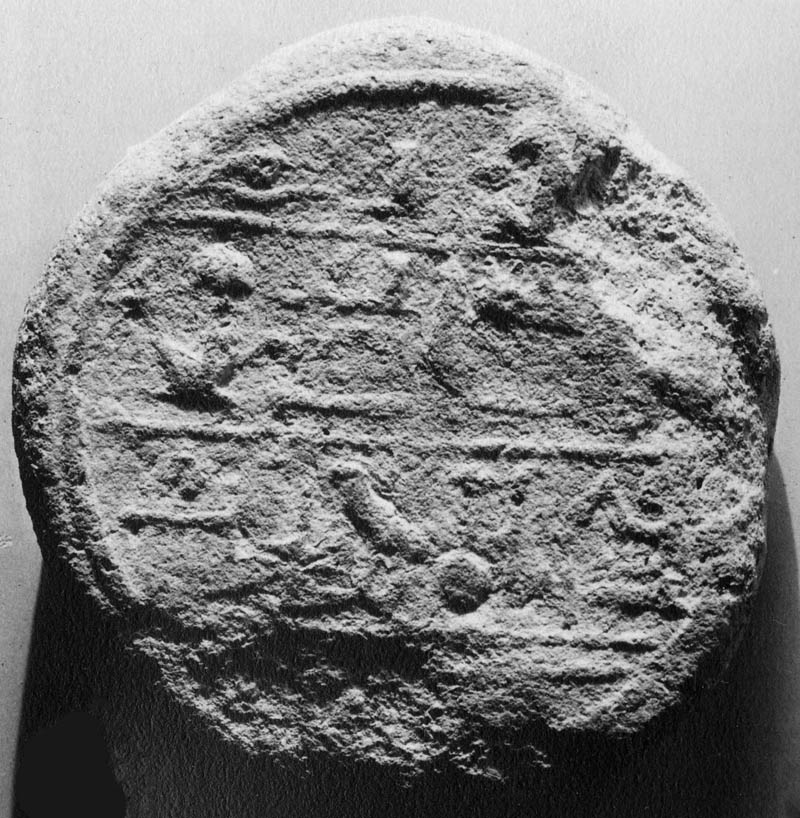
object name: cone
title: Funerary Cone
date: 1550-1295 BCE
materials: pottery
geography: egypt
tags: hieroglyphs